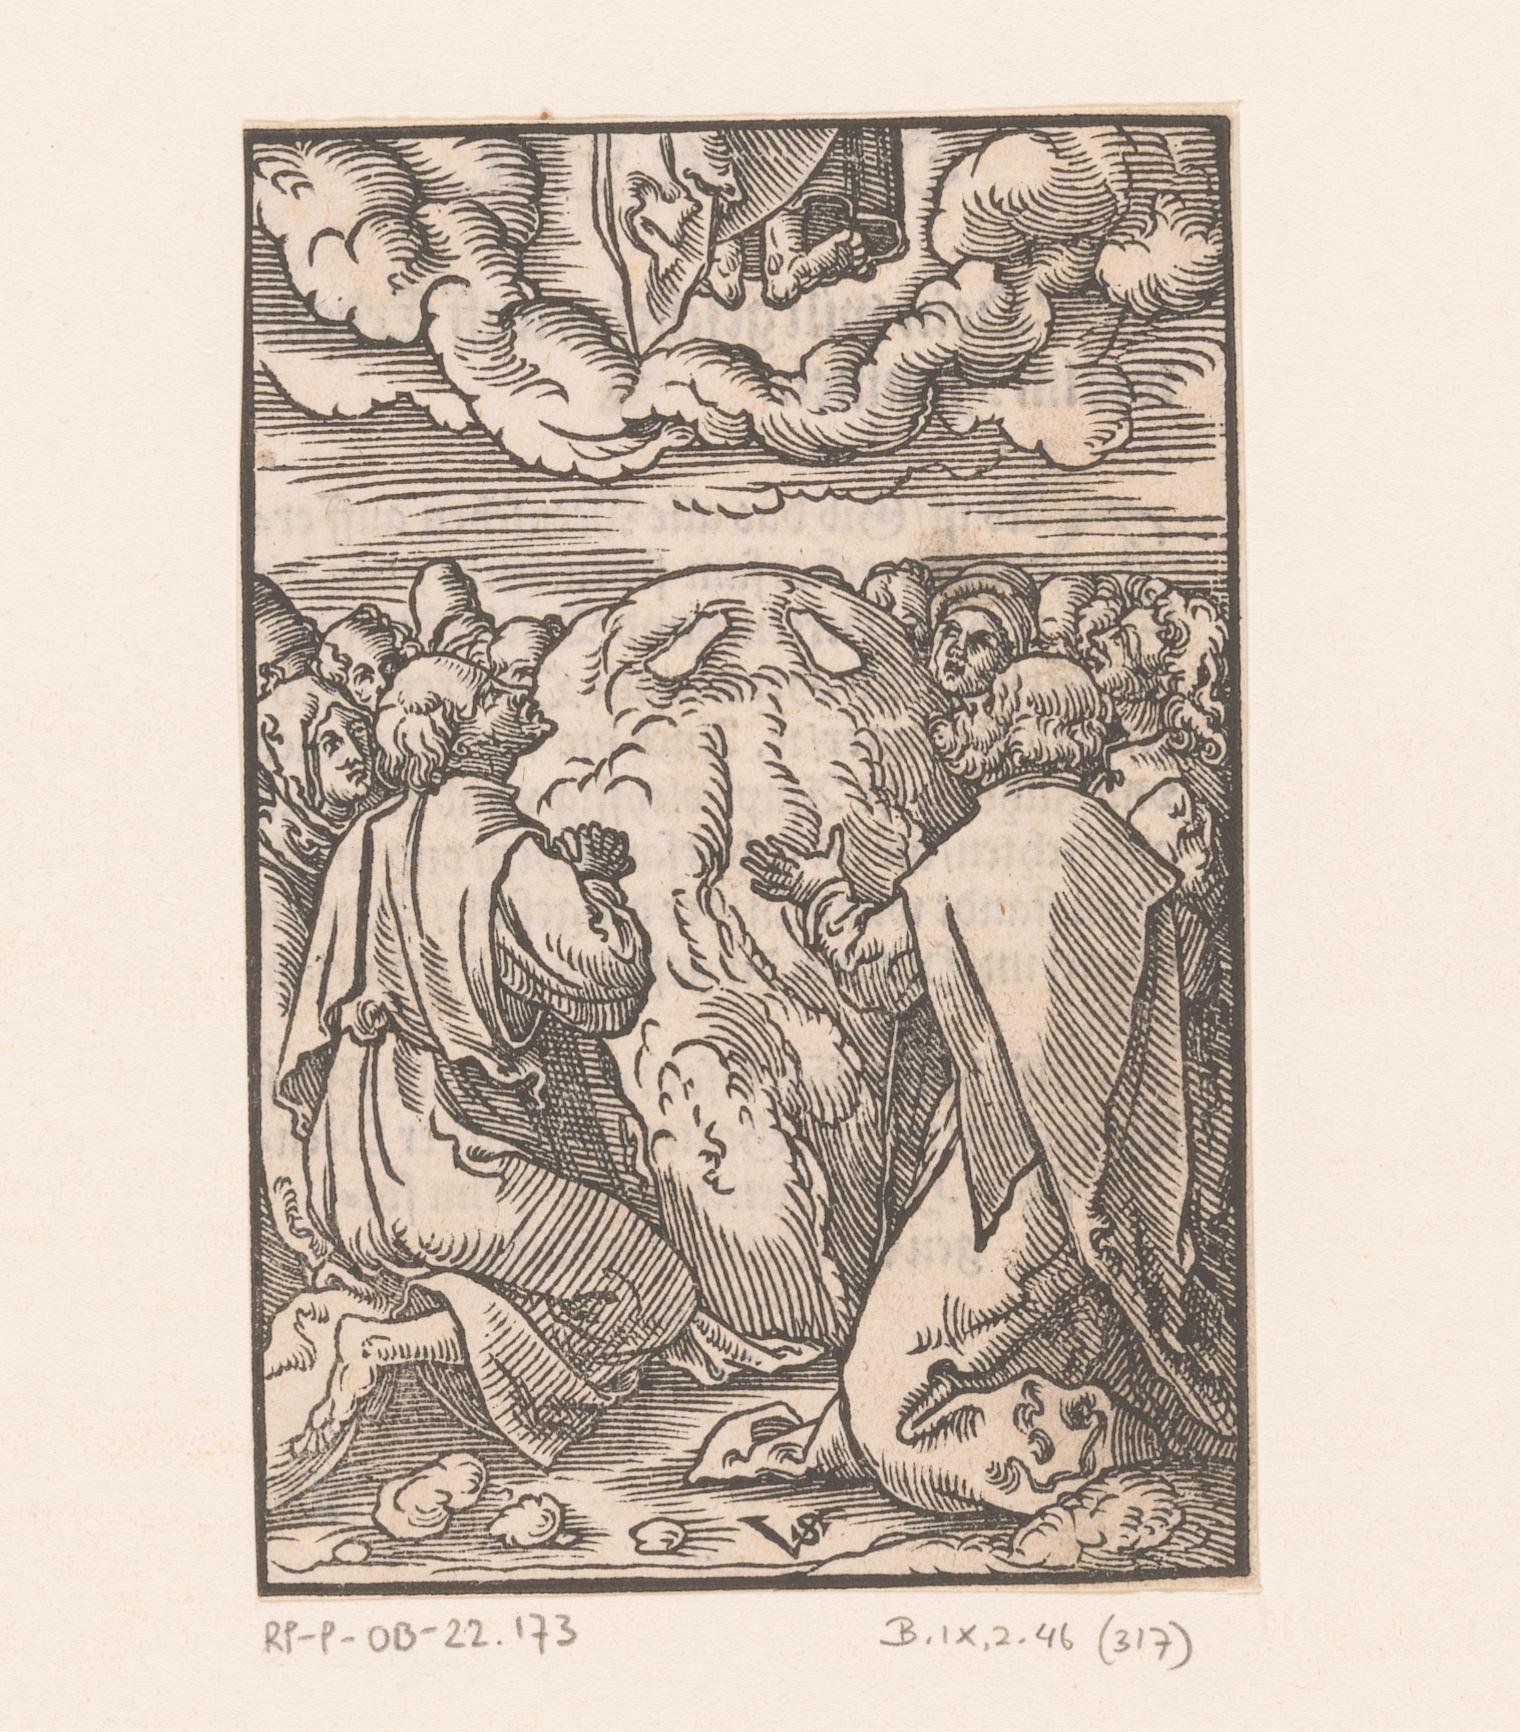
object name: print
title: Hemelvaart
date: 1552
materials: paper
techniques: woodcut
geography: nuremberg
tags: christ ascends into heaven; apostles (and mary) beneath, christ almost vanished: only feet visible ~ ascension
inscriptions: number: ‘181’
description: Gebruikt voor verschillende publicaties die werden gedrukt door Valentin Geißler tussen 1552 en 1560 te Neurenberg.